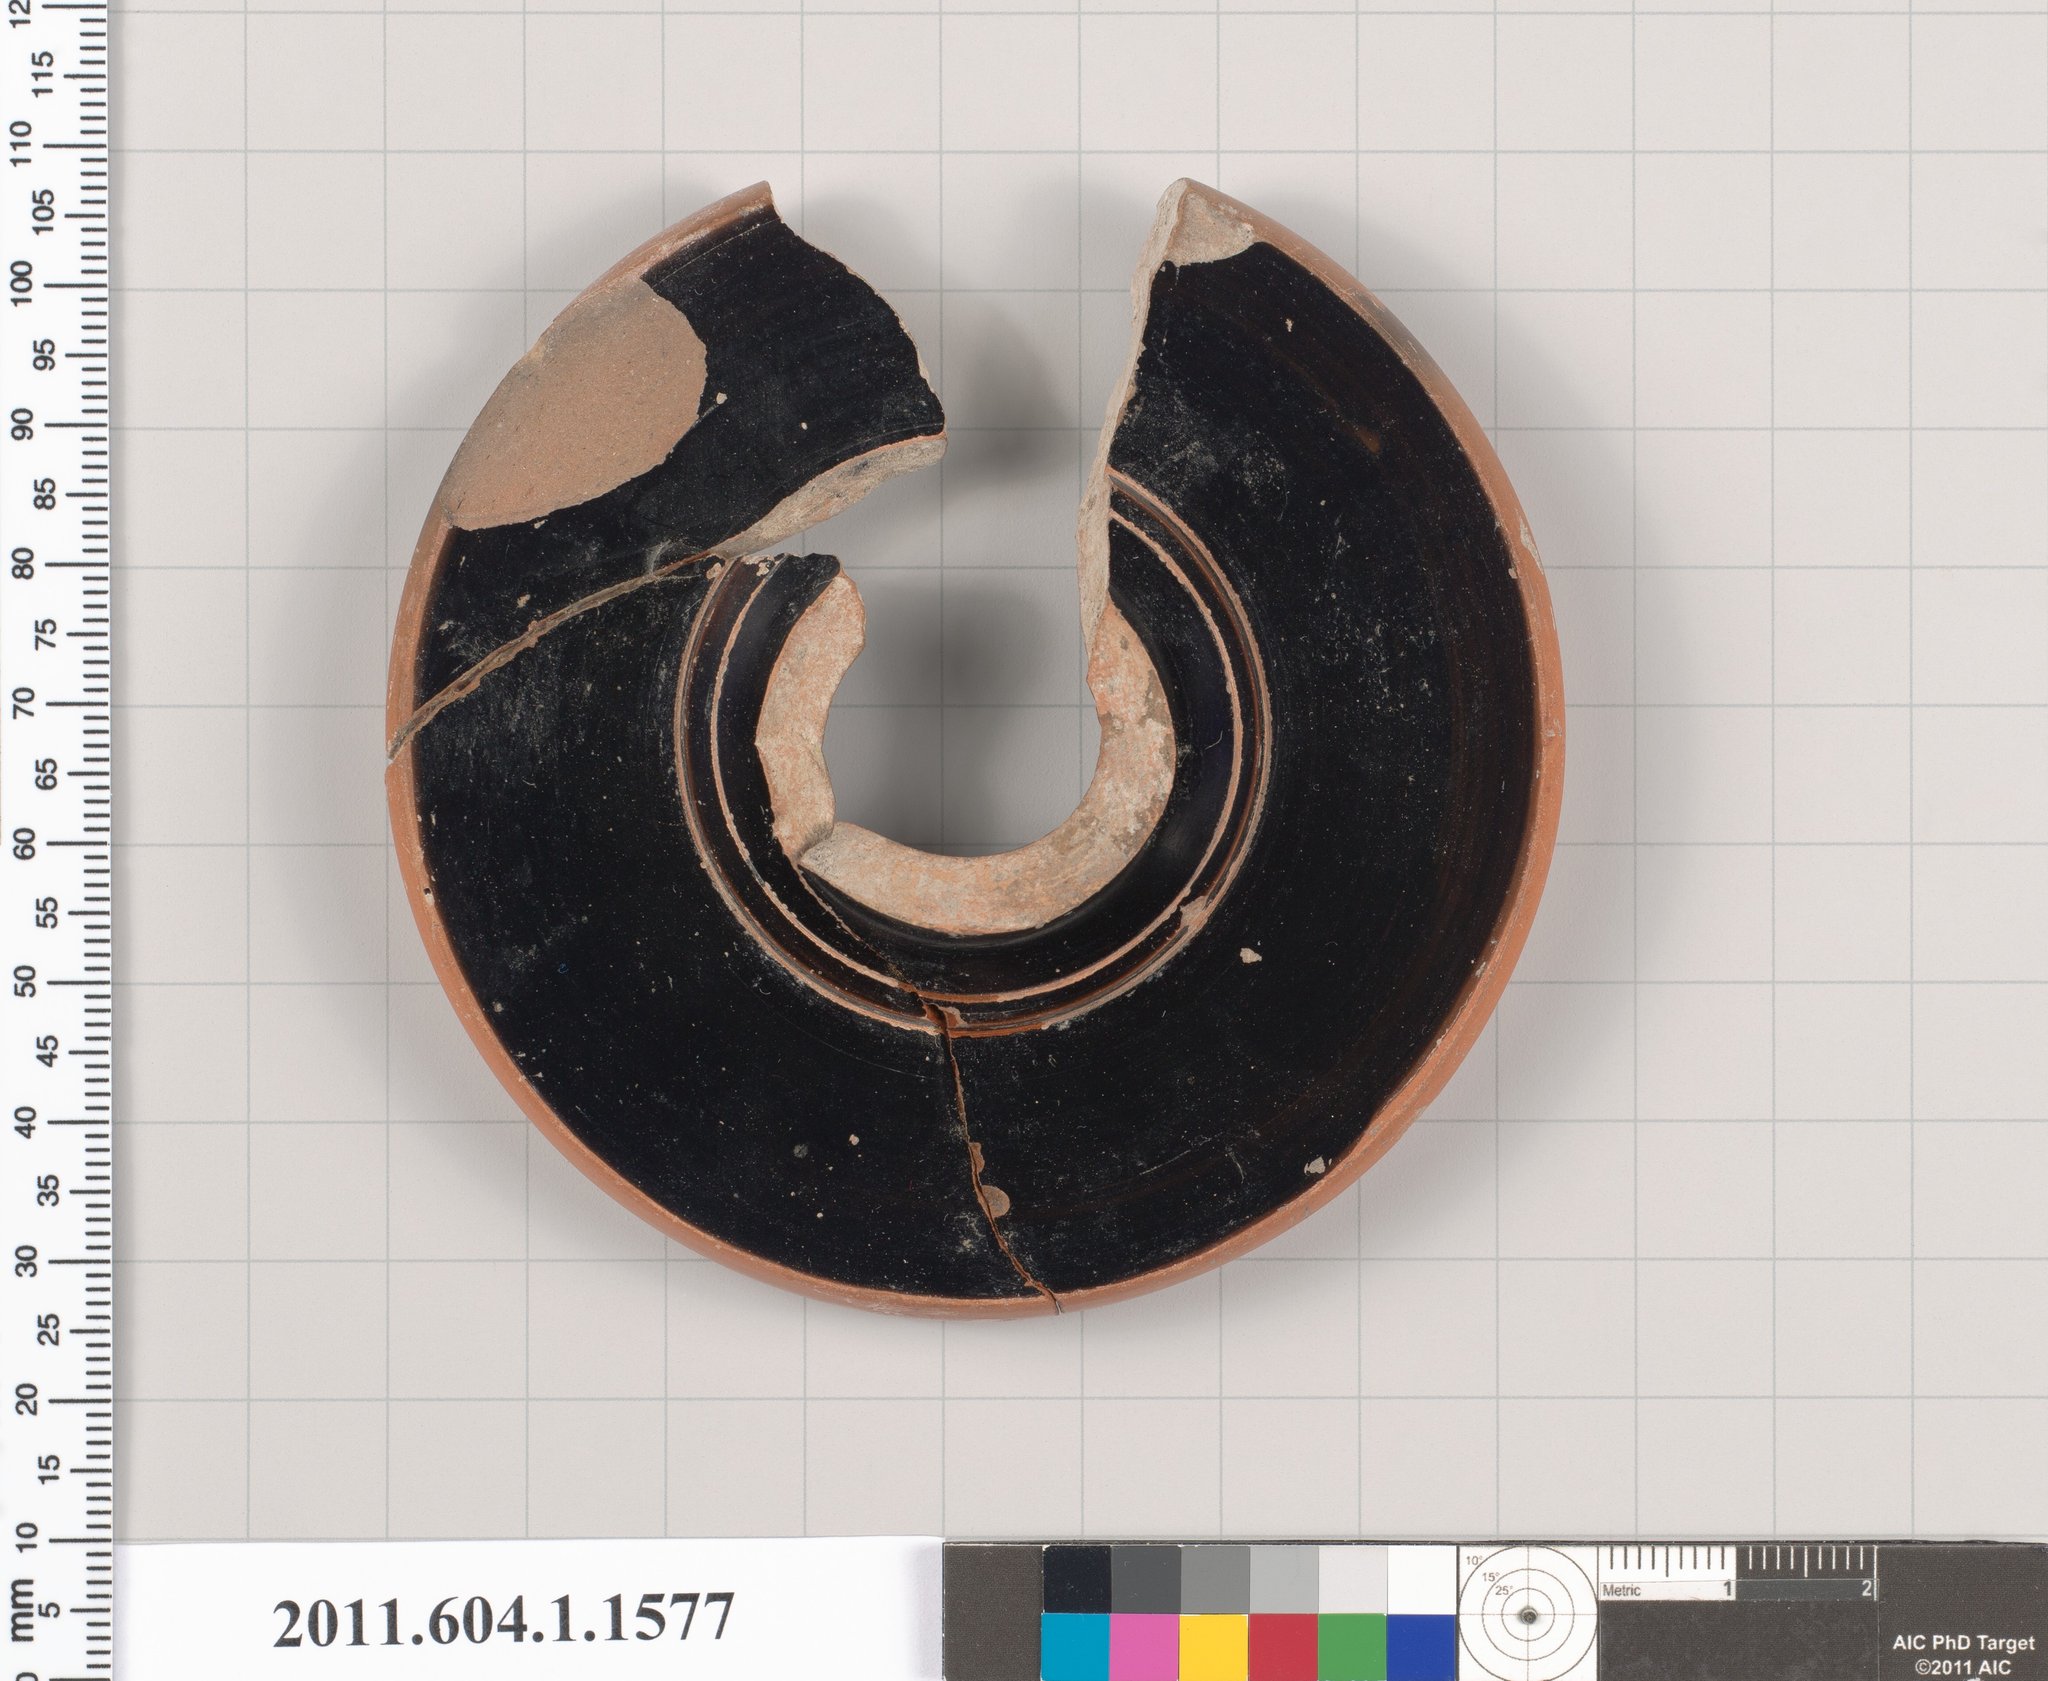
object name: kylix fragment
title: Terracotta fragment of a kylix (drinking cup)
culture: greek, attic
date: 500-401 BCE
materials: terracotta